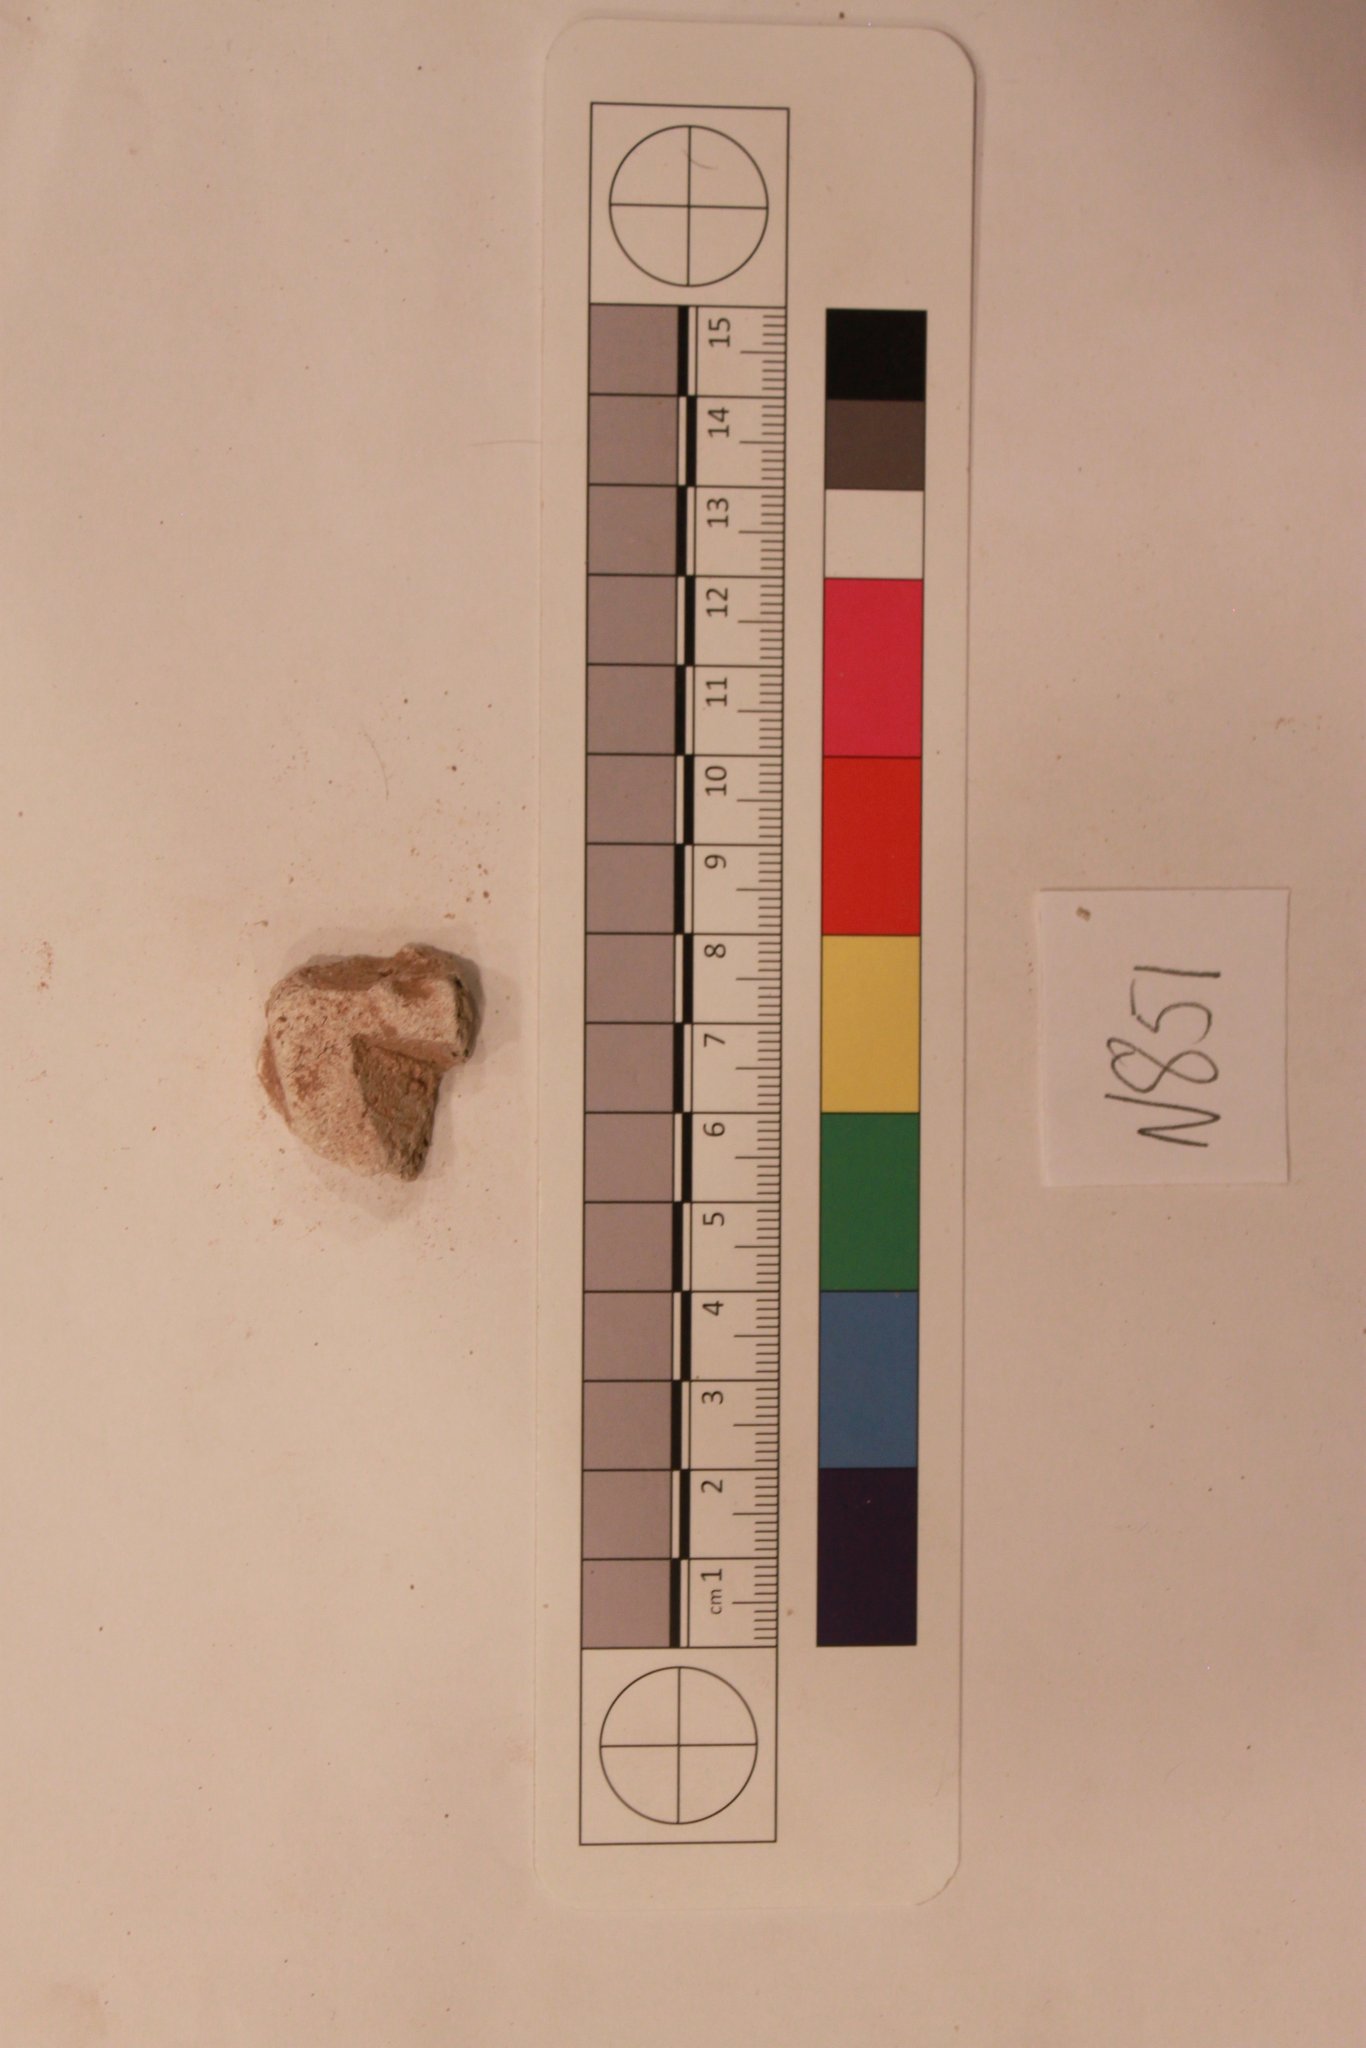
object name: fragment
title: Stucco Fragment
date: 701-1200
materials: plaster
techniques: carving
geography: iran